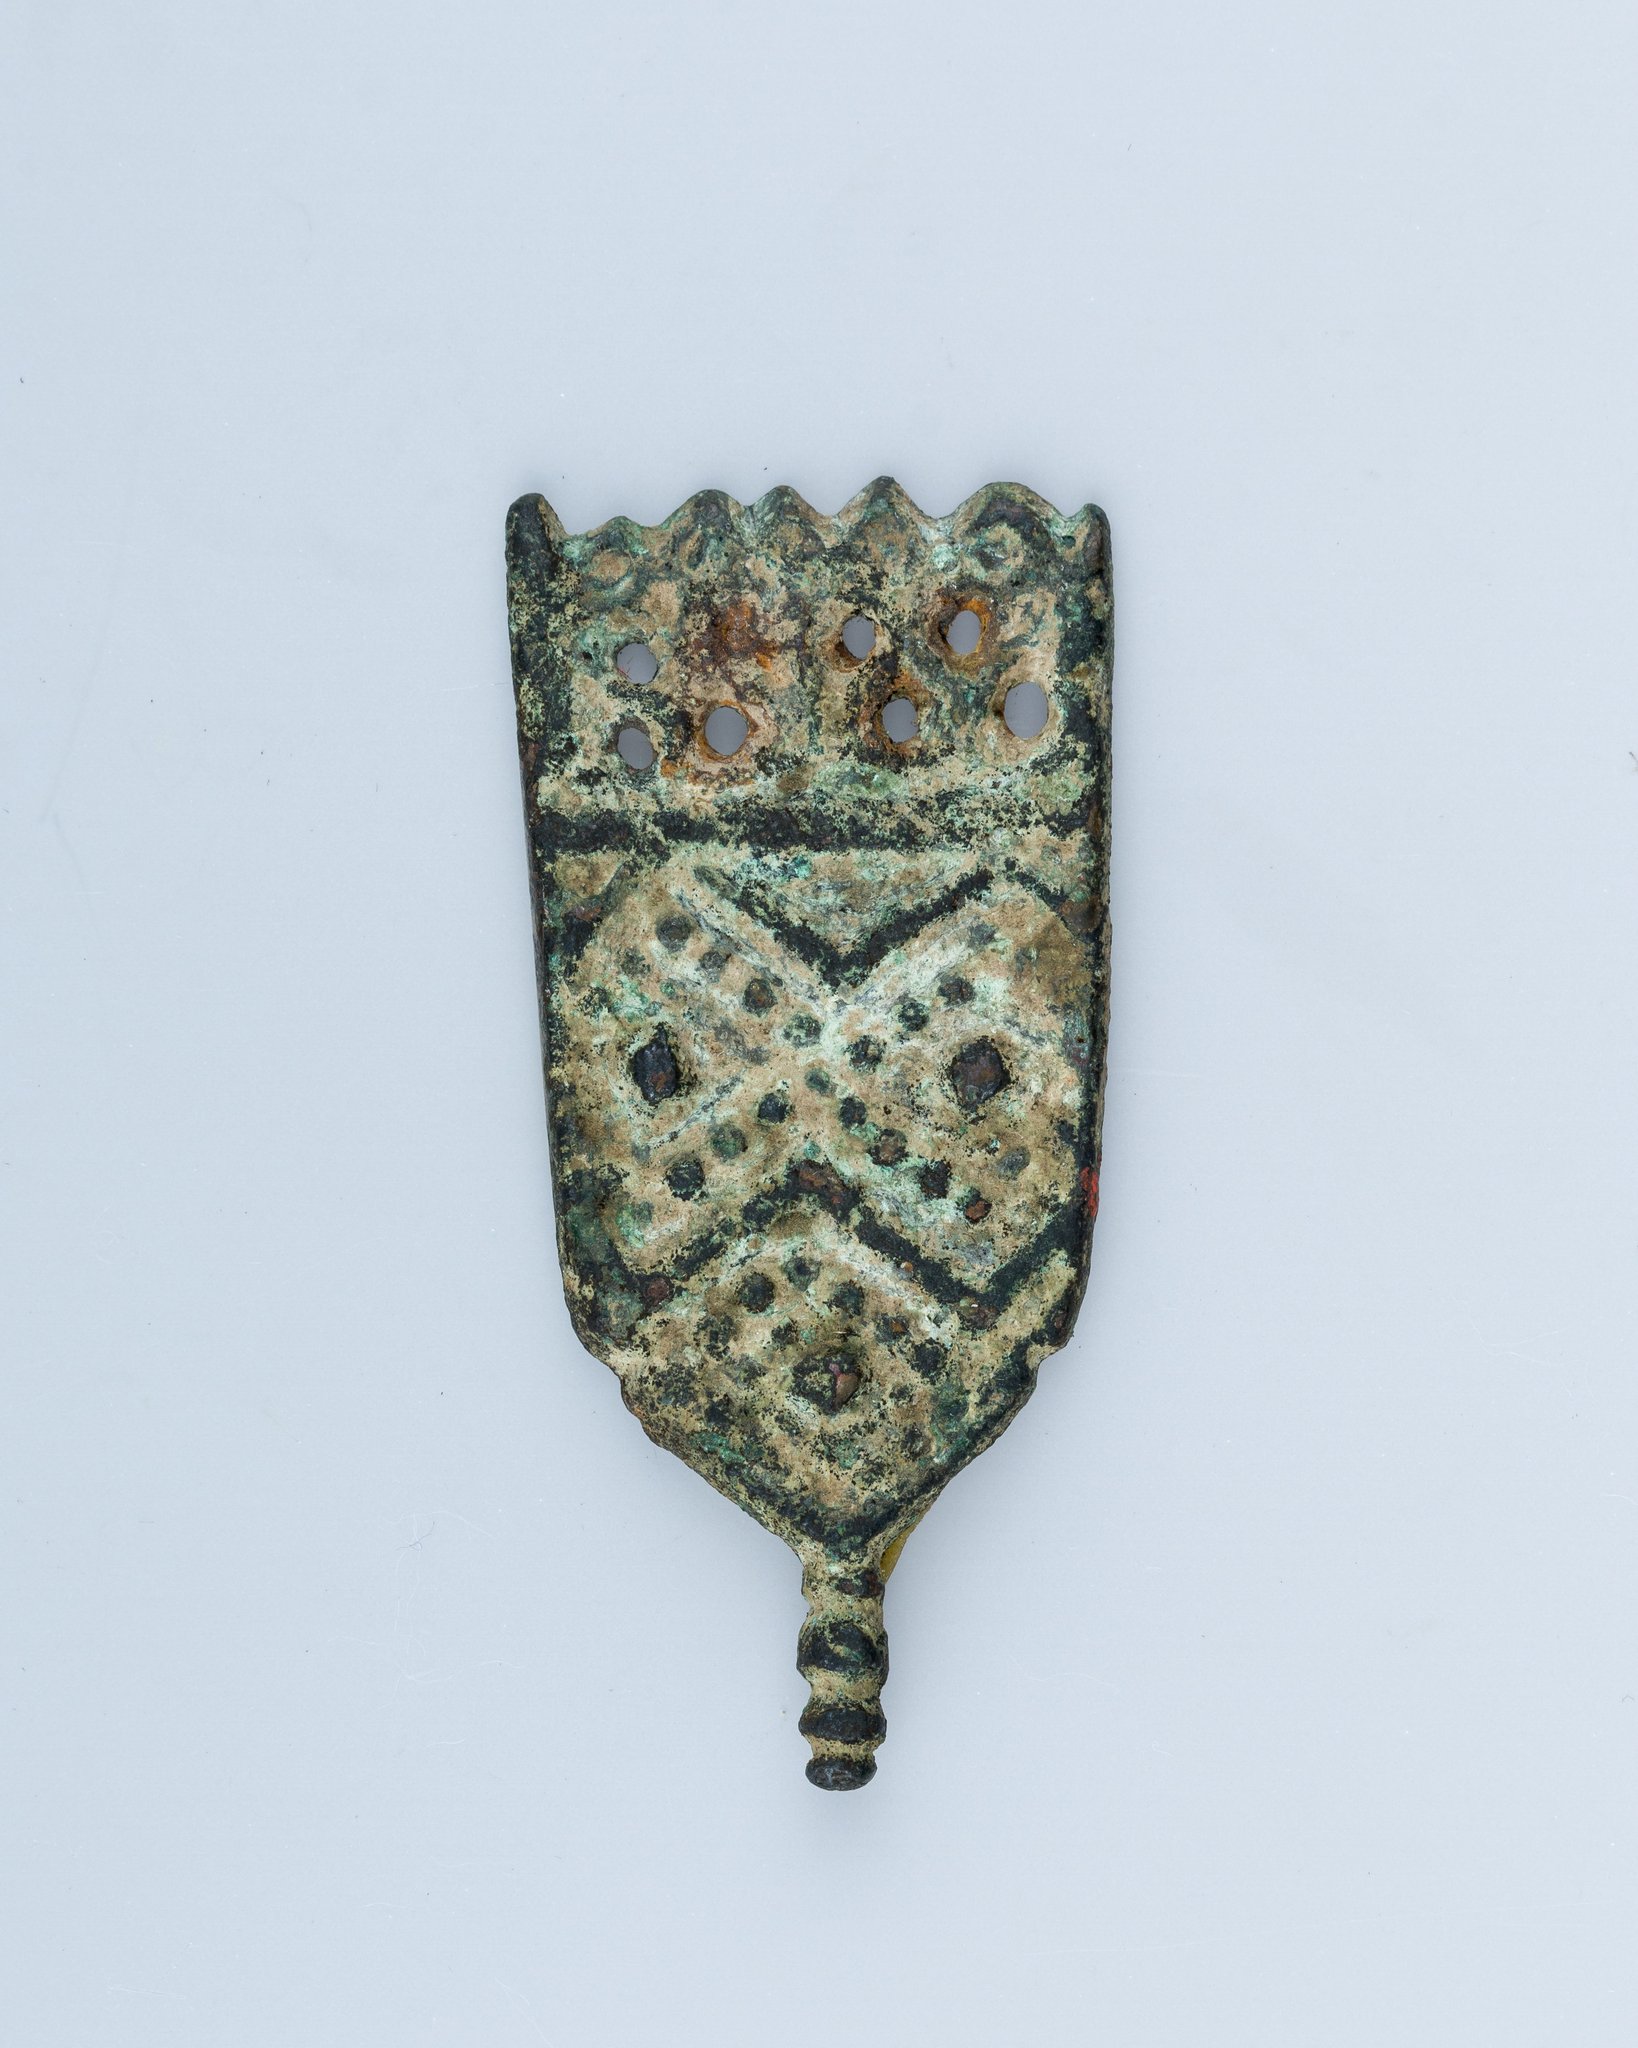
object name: pendant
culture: french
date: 1401-1500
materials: bronze, patina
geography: france